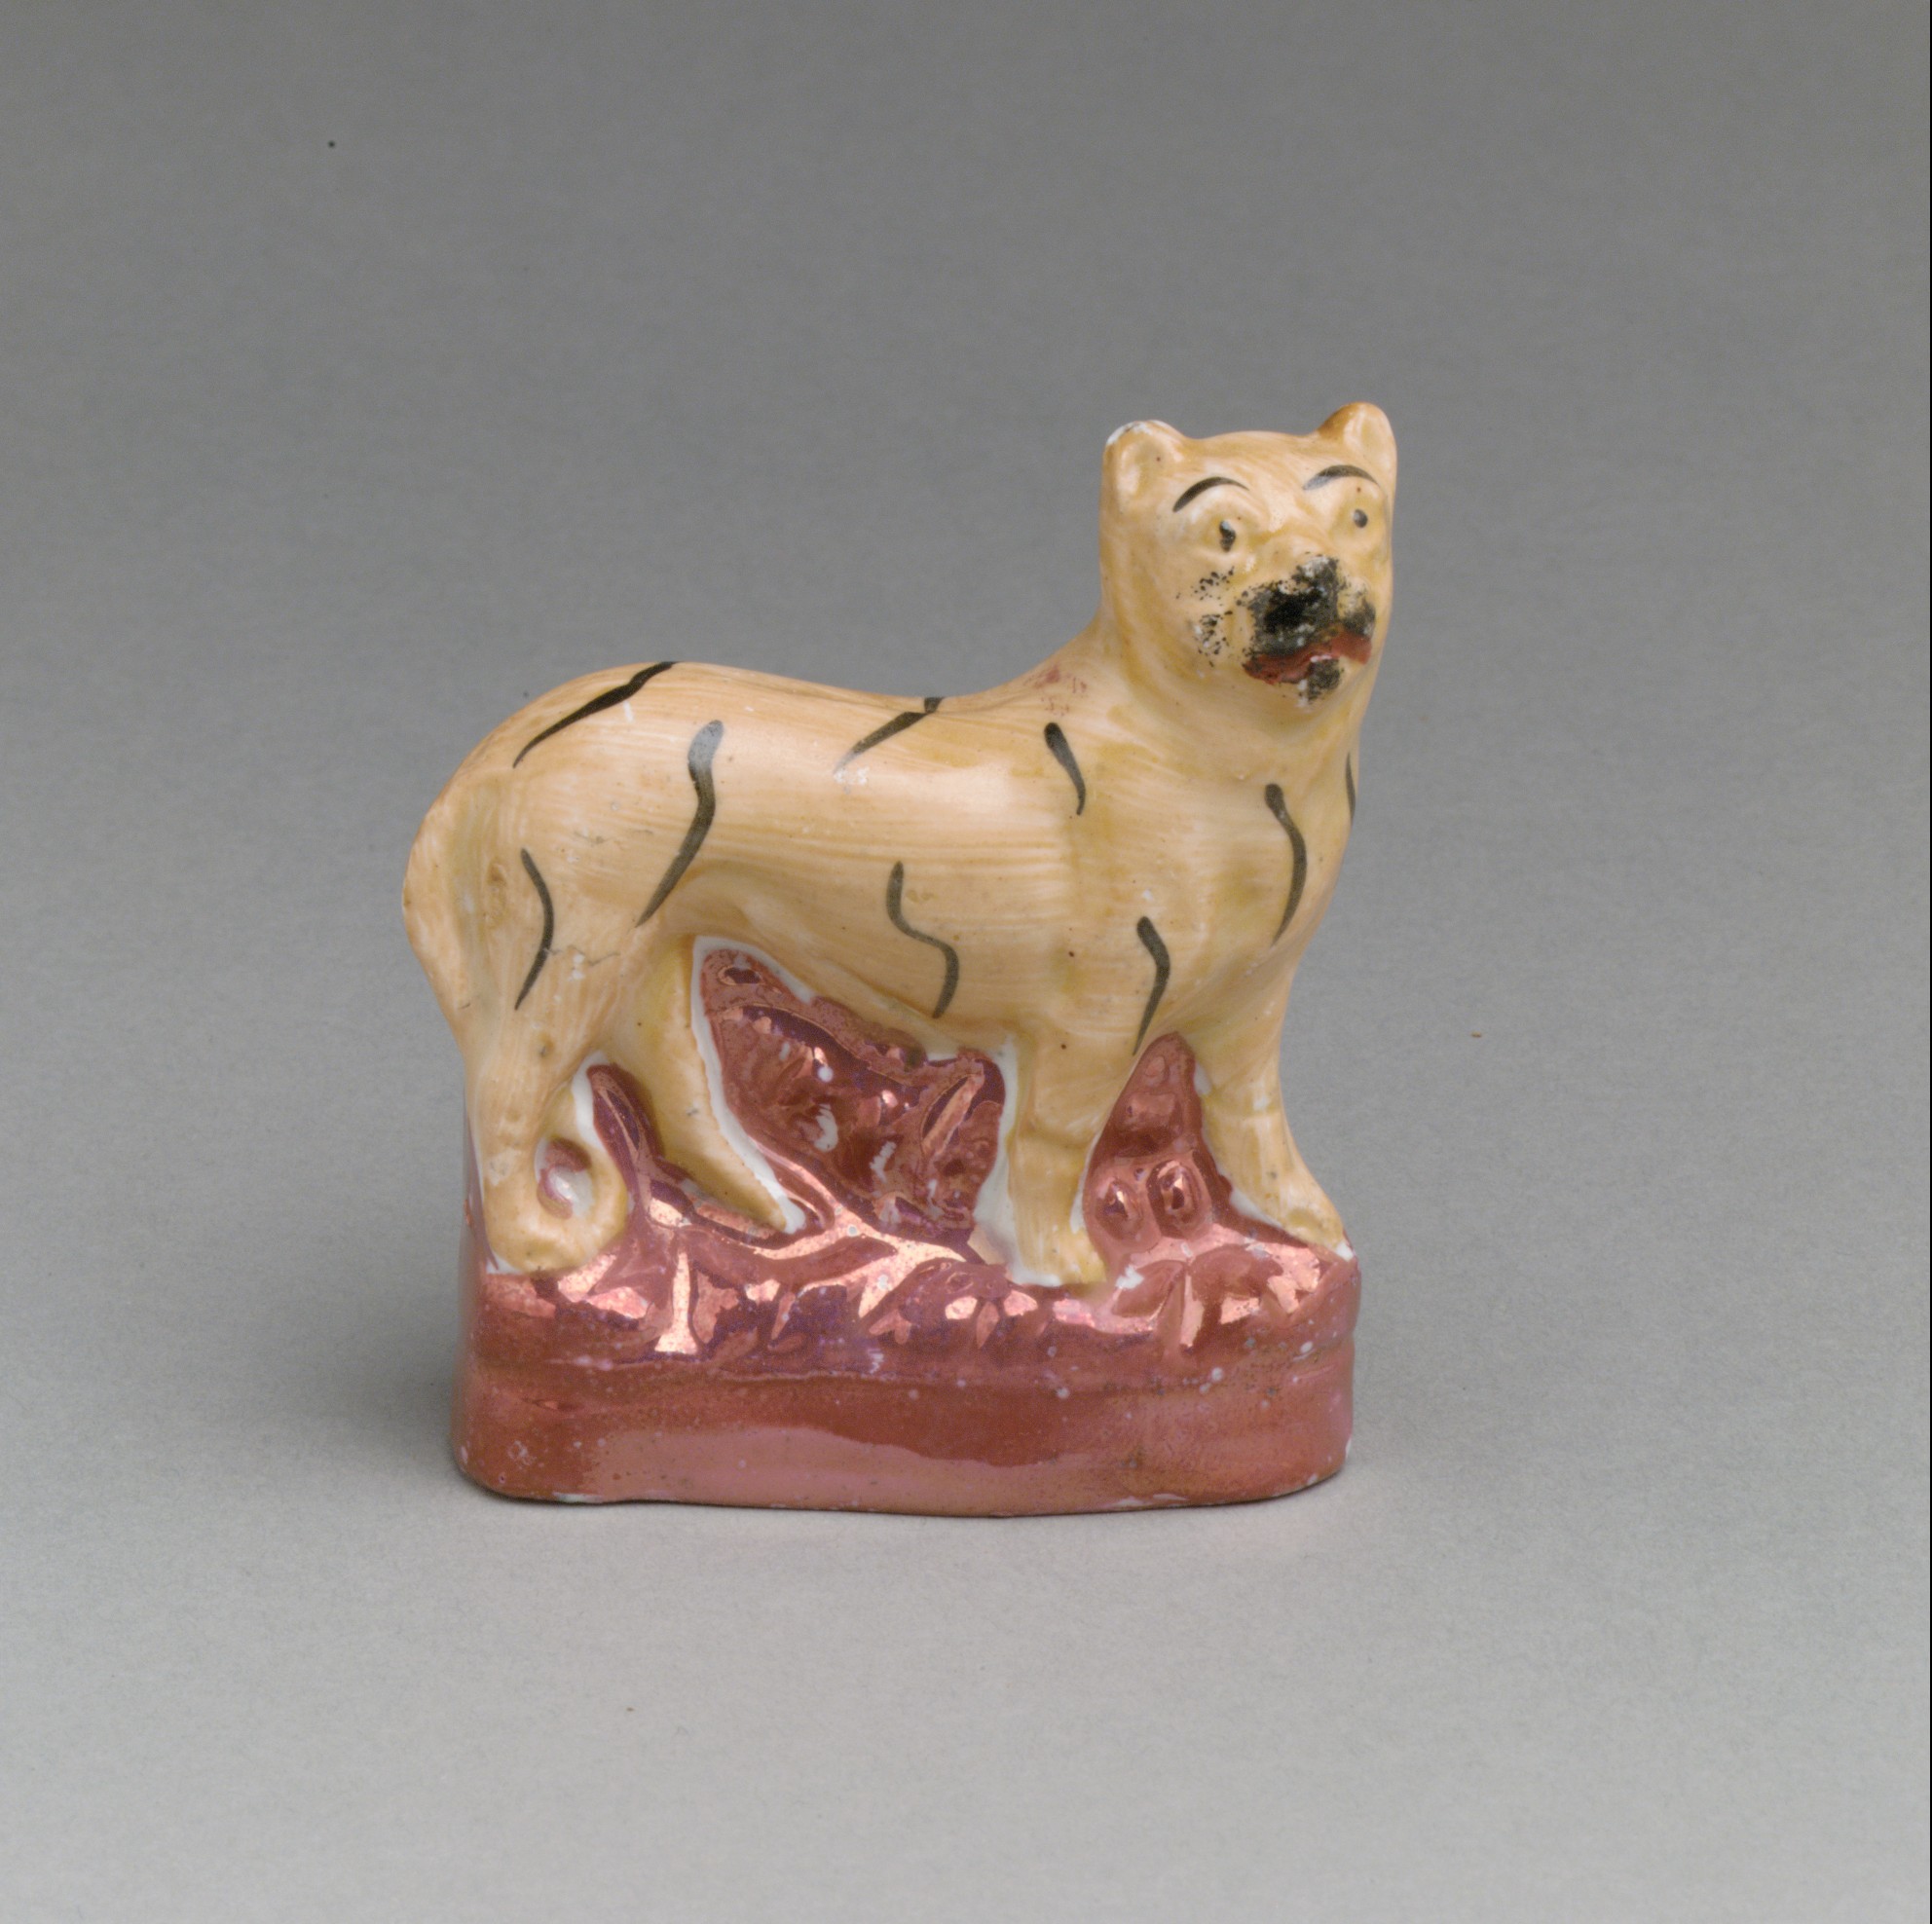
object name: figure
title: Tiger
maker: mary atwood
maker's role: artist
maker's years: 1800-1900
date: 1801-1900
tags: tigers